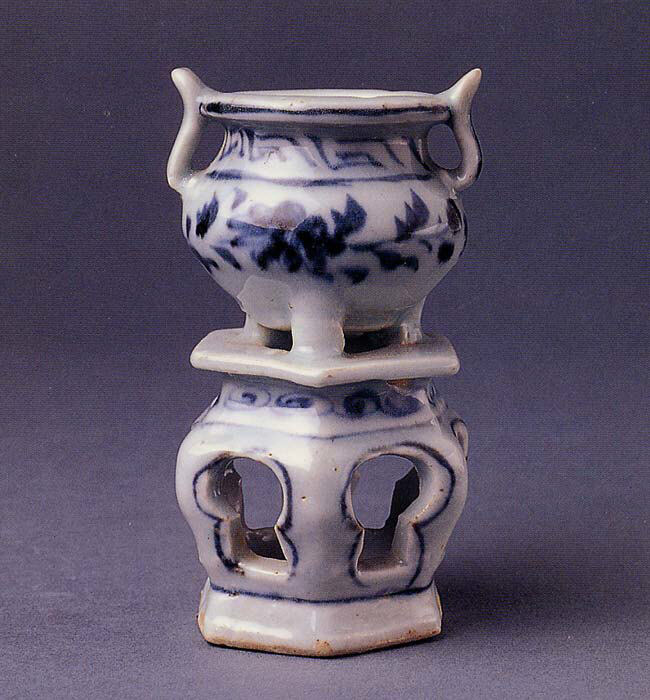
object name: censer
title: Censer on Attached Stand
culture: chinese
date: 1301-1433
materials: porcelain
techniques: painting, underglaze